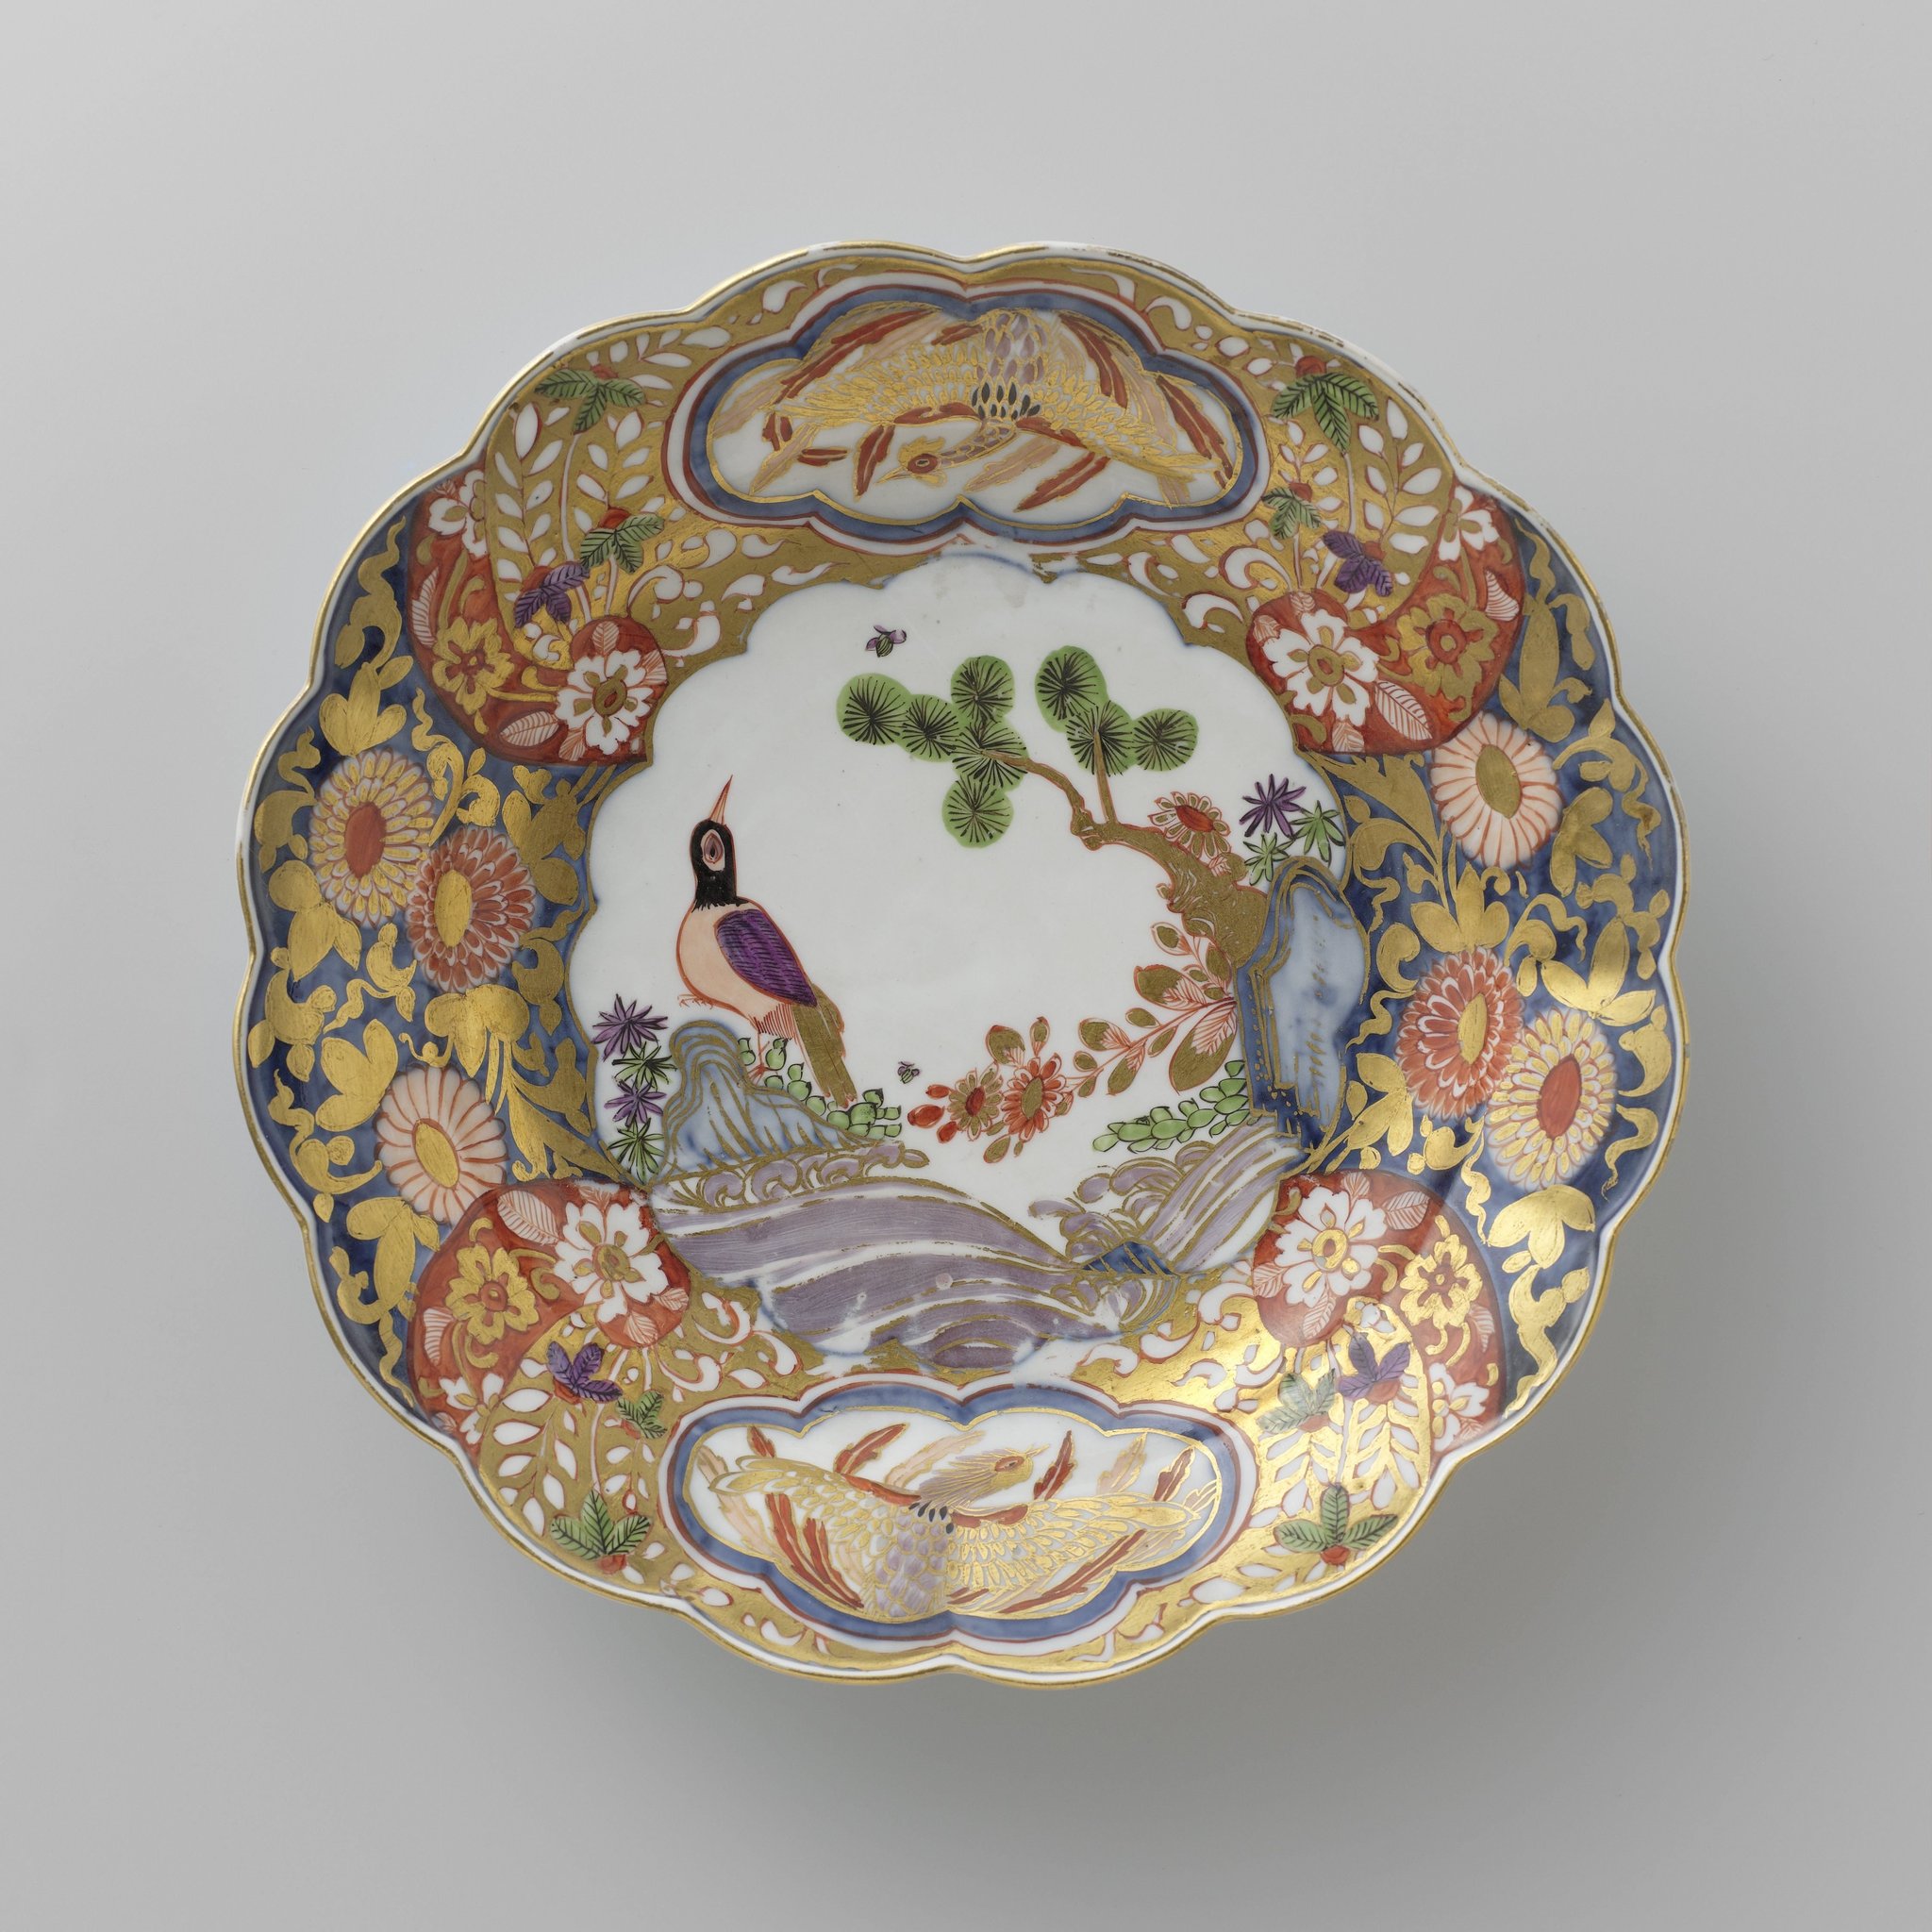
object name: plate dish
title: Bord, beschilderd met een Imari-decor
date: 1740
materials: porcelain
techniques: painted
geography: meissen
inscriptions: factory mark, mold mark: ‘22’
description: Dish and plates. Porcelain. Meissen, c. 1740 after a Japanese Imari model.